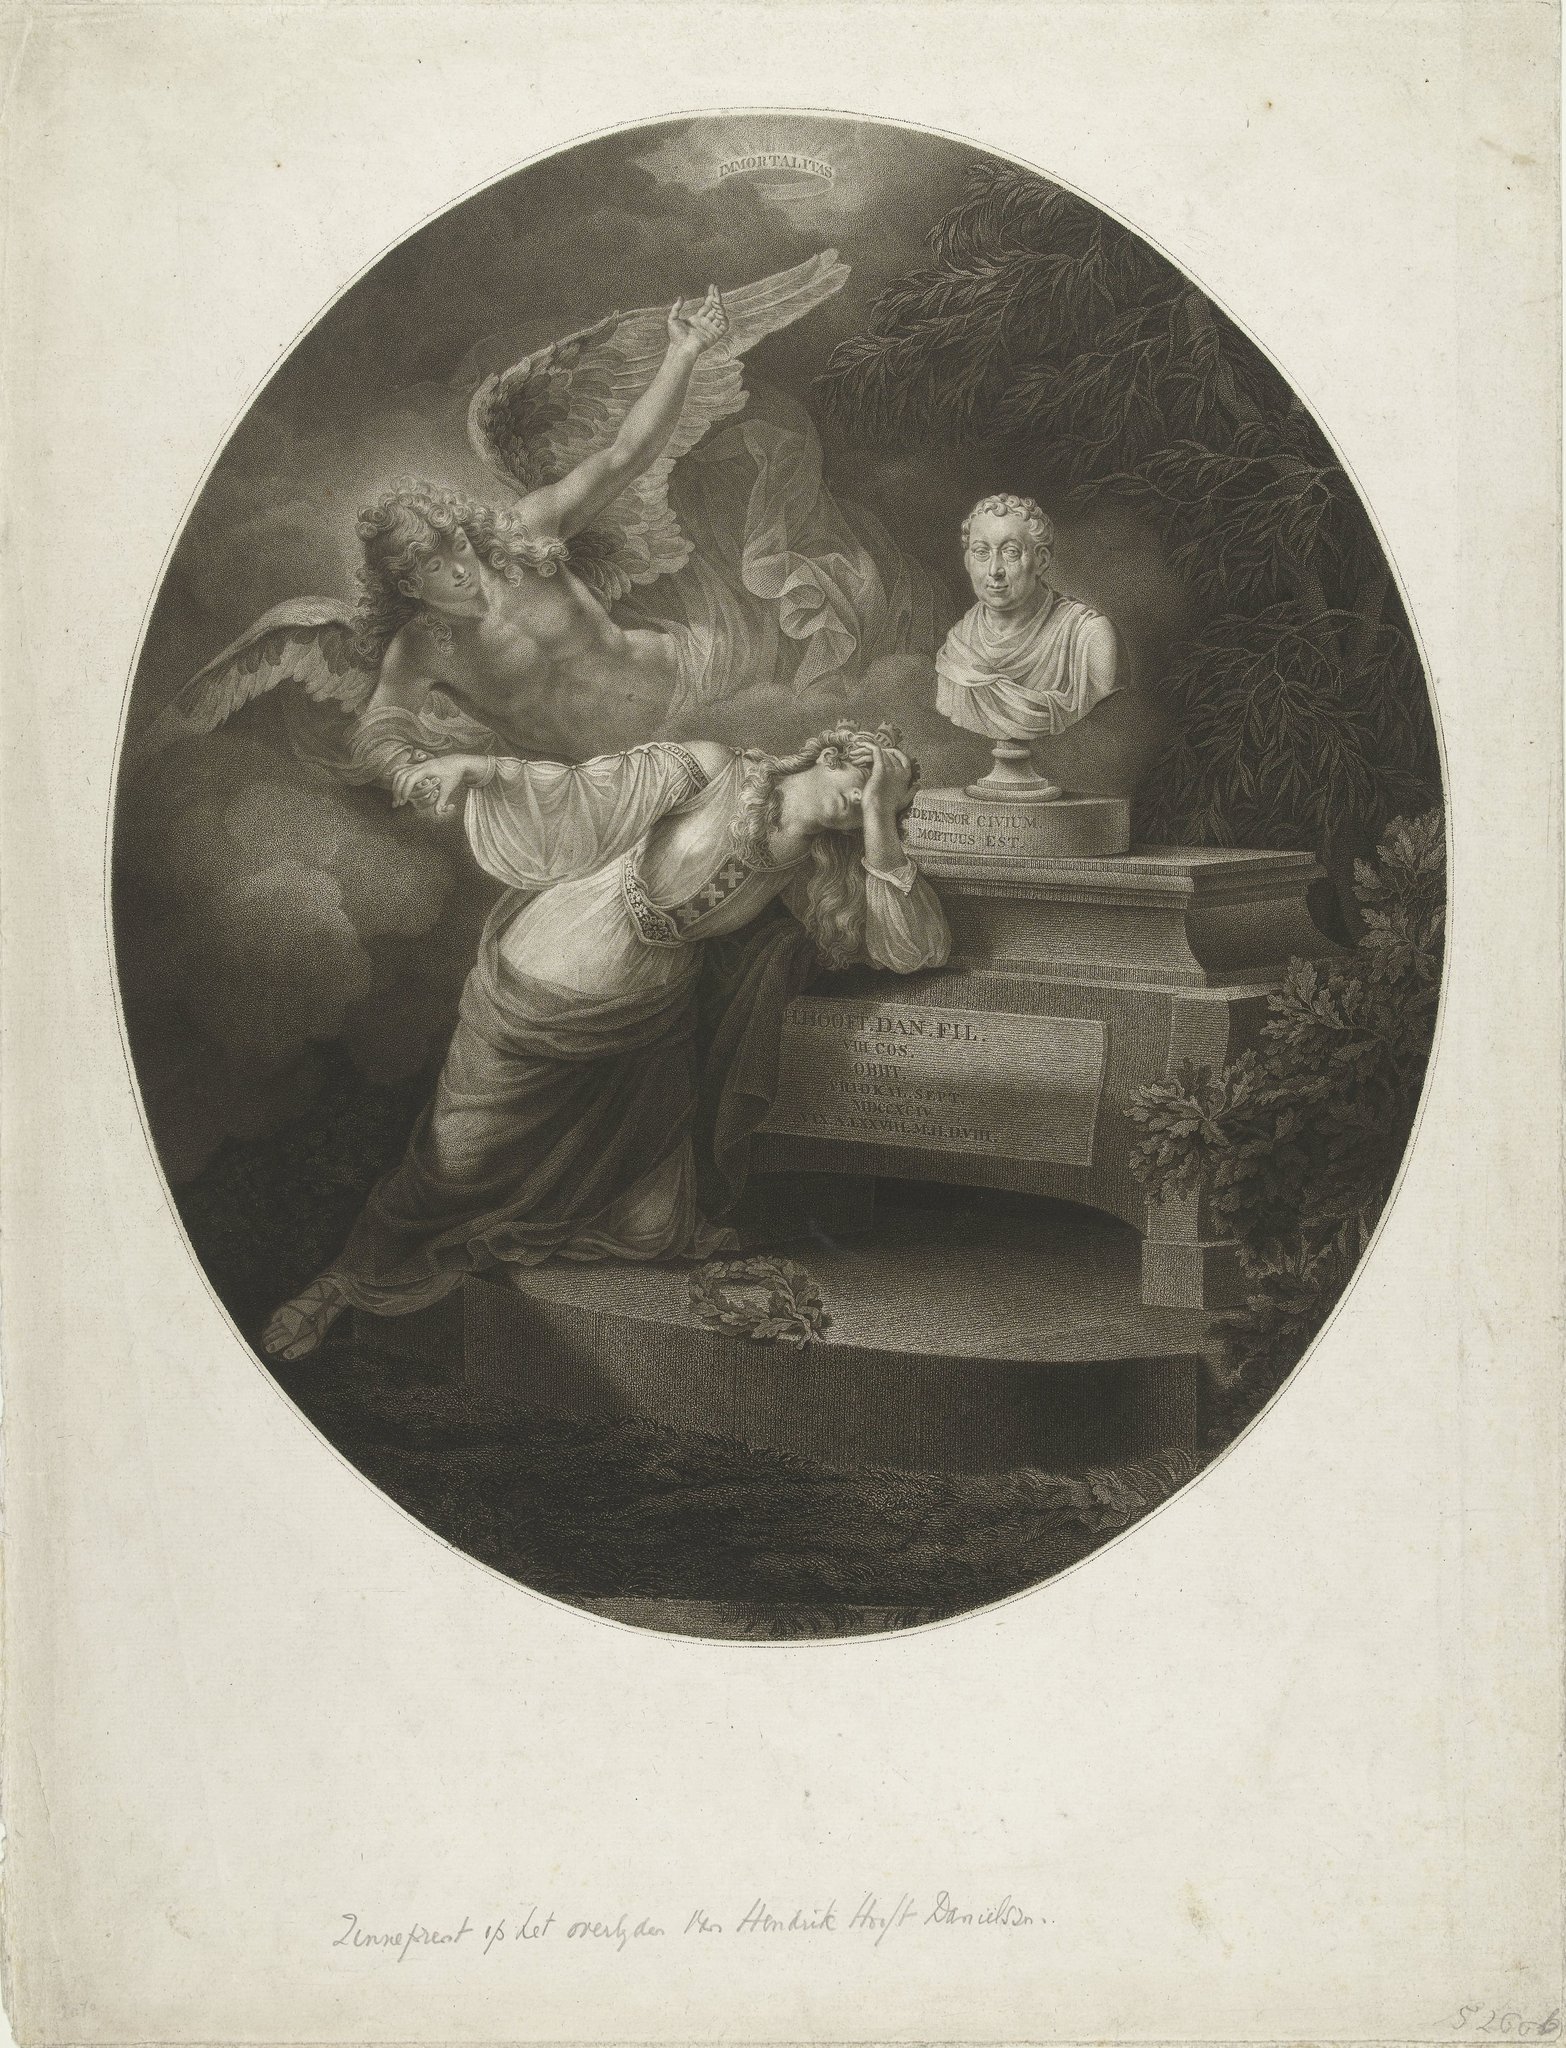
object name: print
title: Memorieprent voor Hendrik Hooft Daniëlsz.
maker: lambertus antonius claessens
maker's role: draughtsman, print maker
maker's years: 1763-1834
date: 1794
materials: paper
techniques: etching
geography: amsterdam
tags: amsterdam, mayor, hendrik danielsz. hooft, personification of a city, town-patron(ess), grave, tomb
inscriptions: collector's mark: Lugt 2228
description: De Amsterdamse stedenmaagd rouwt bij het graf van de Amsterdamse burgermeester Hendrik Hooft Daniëlsz. Een engel steunt haar in het verdriet en wijst haar op de onsterfelijkheid van de overledene. Op de graftombe staat een portretbuste van Hooft Daniëlsz. in antieke stijl.